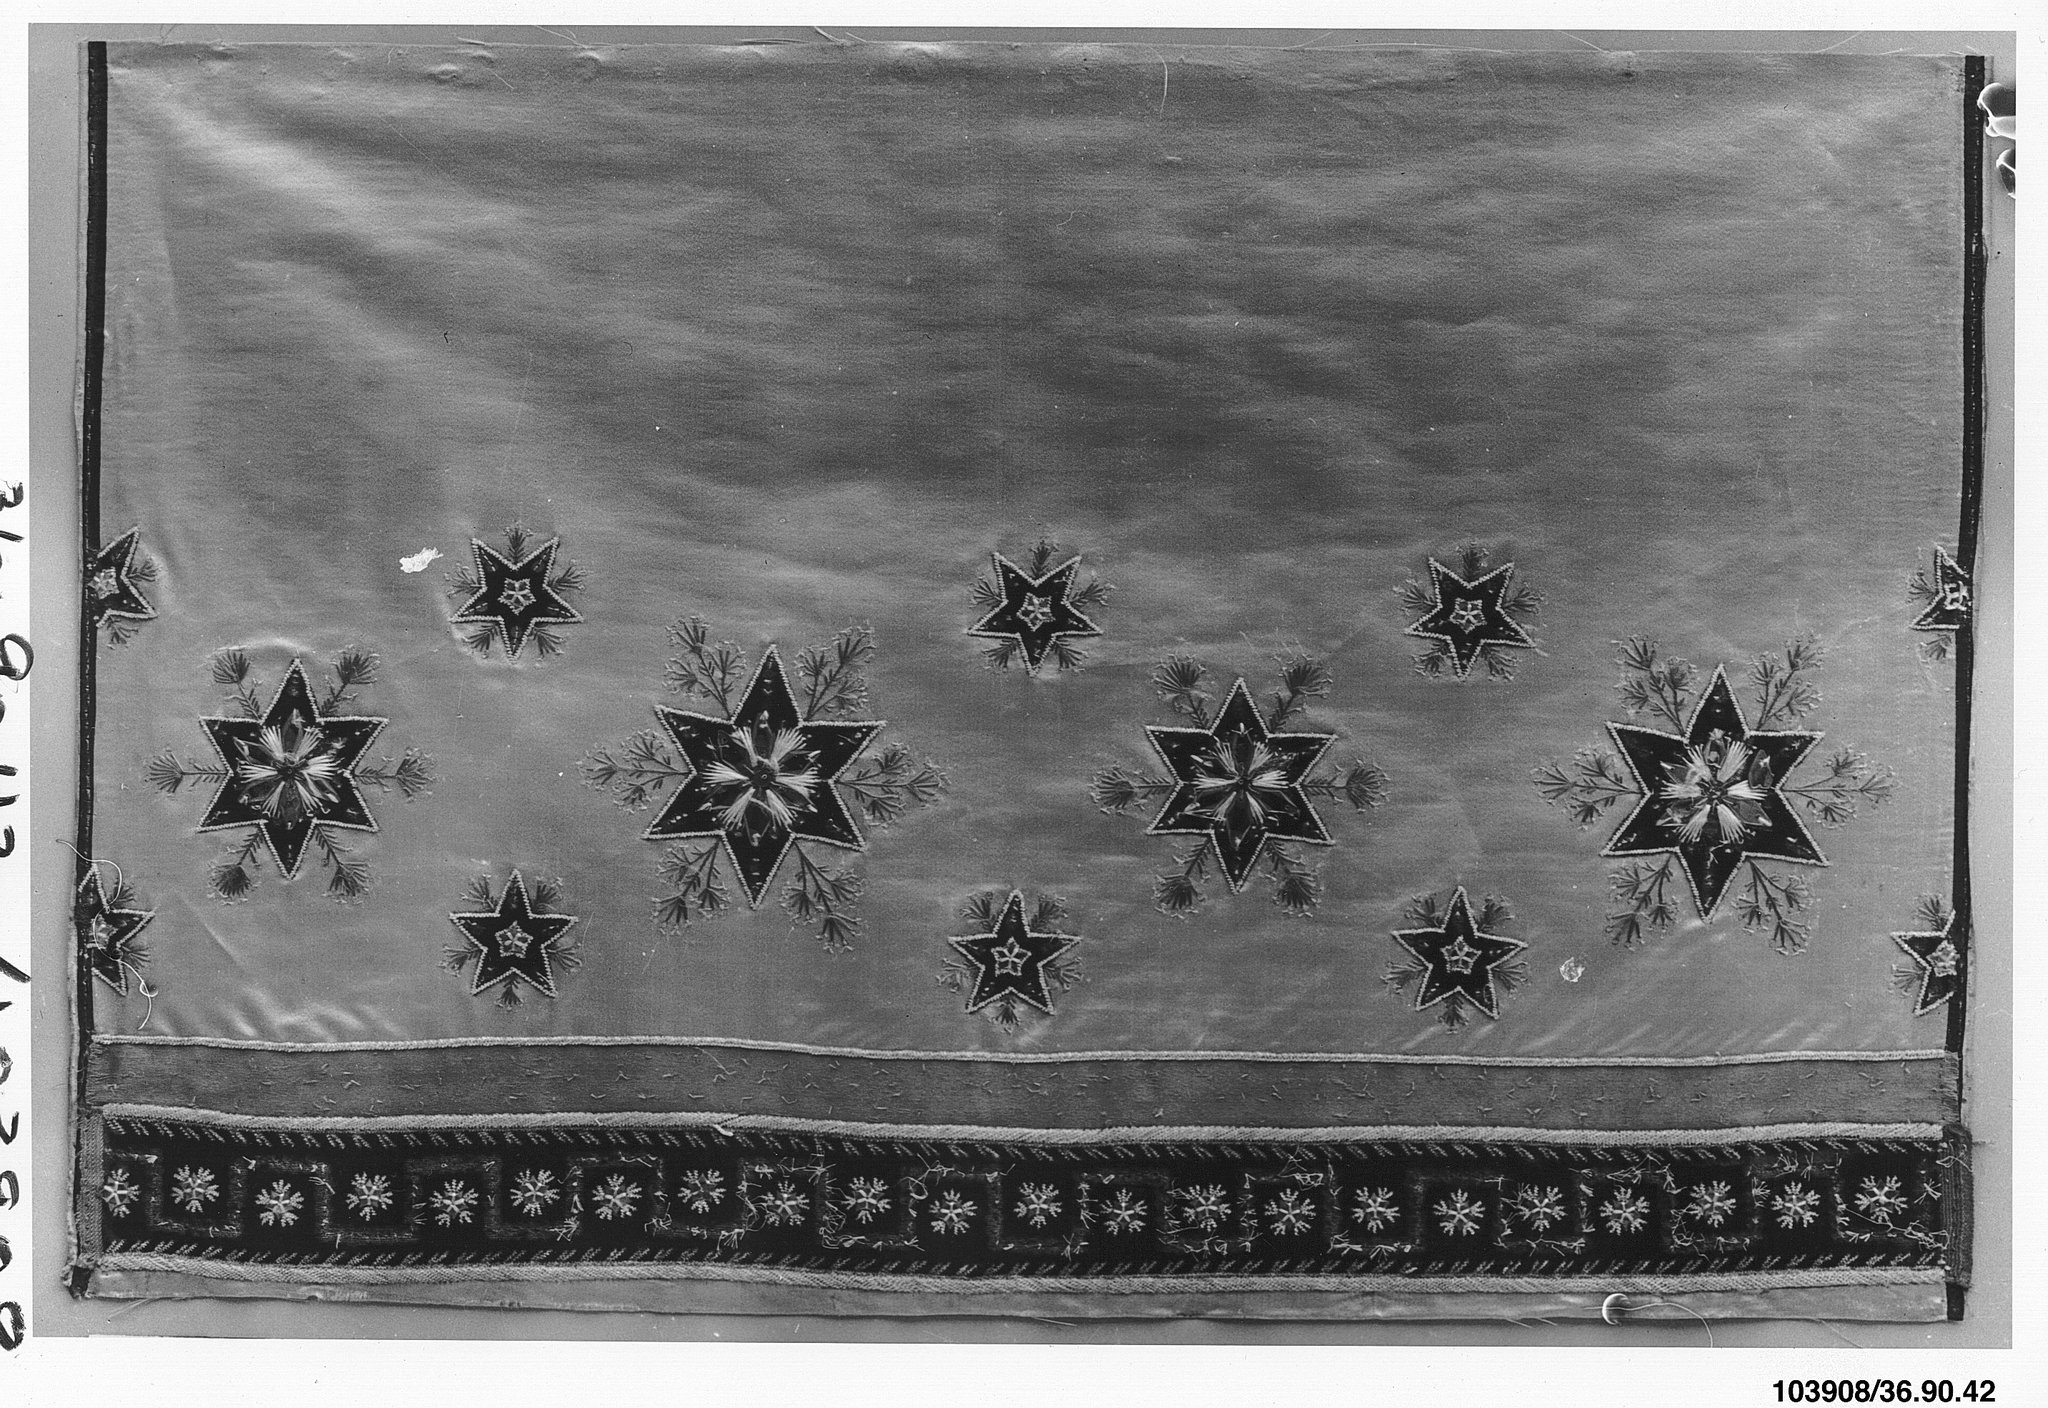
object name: border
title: Dress border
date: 1801-1833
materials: glass, silk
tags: stars